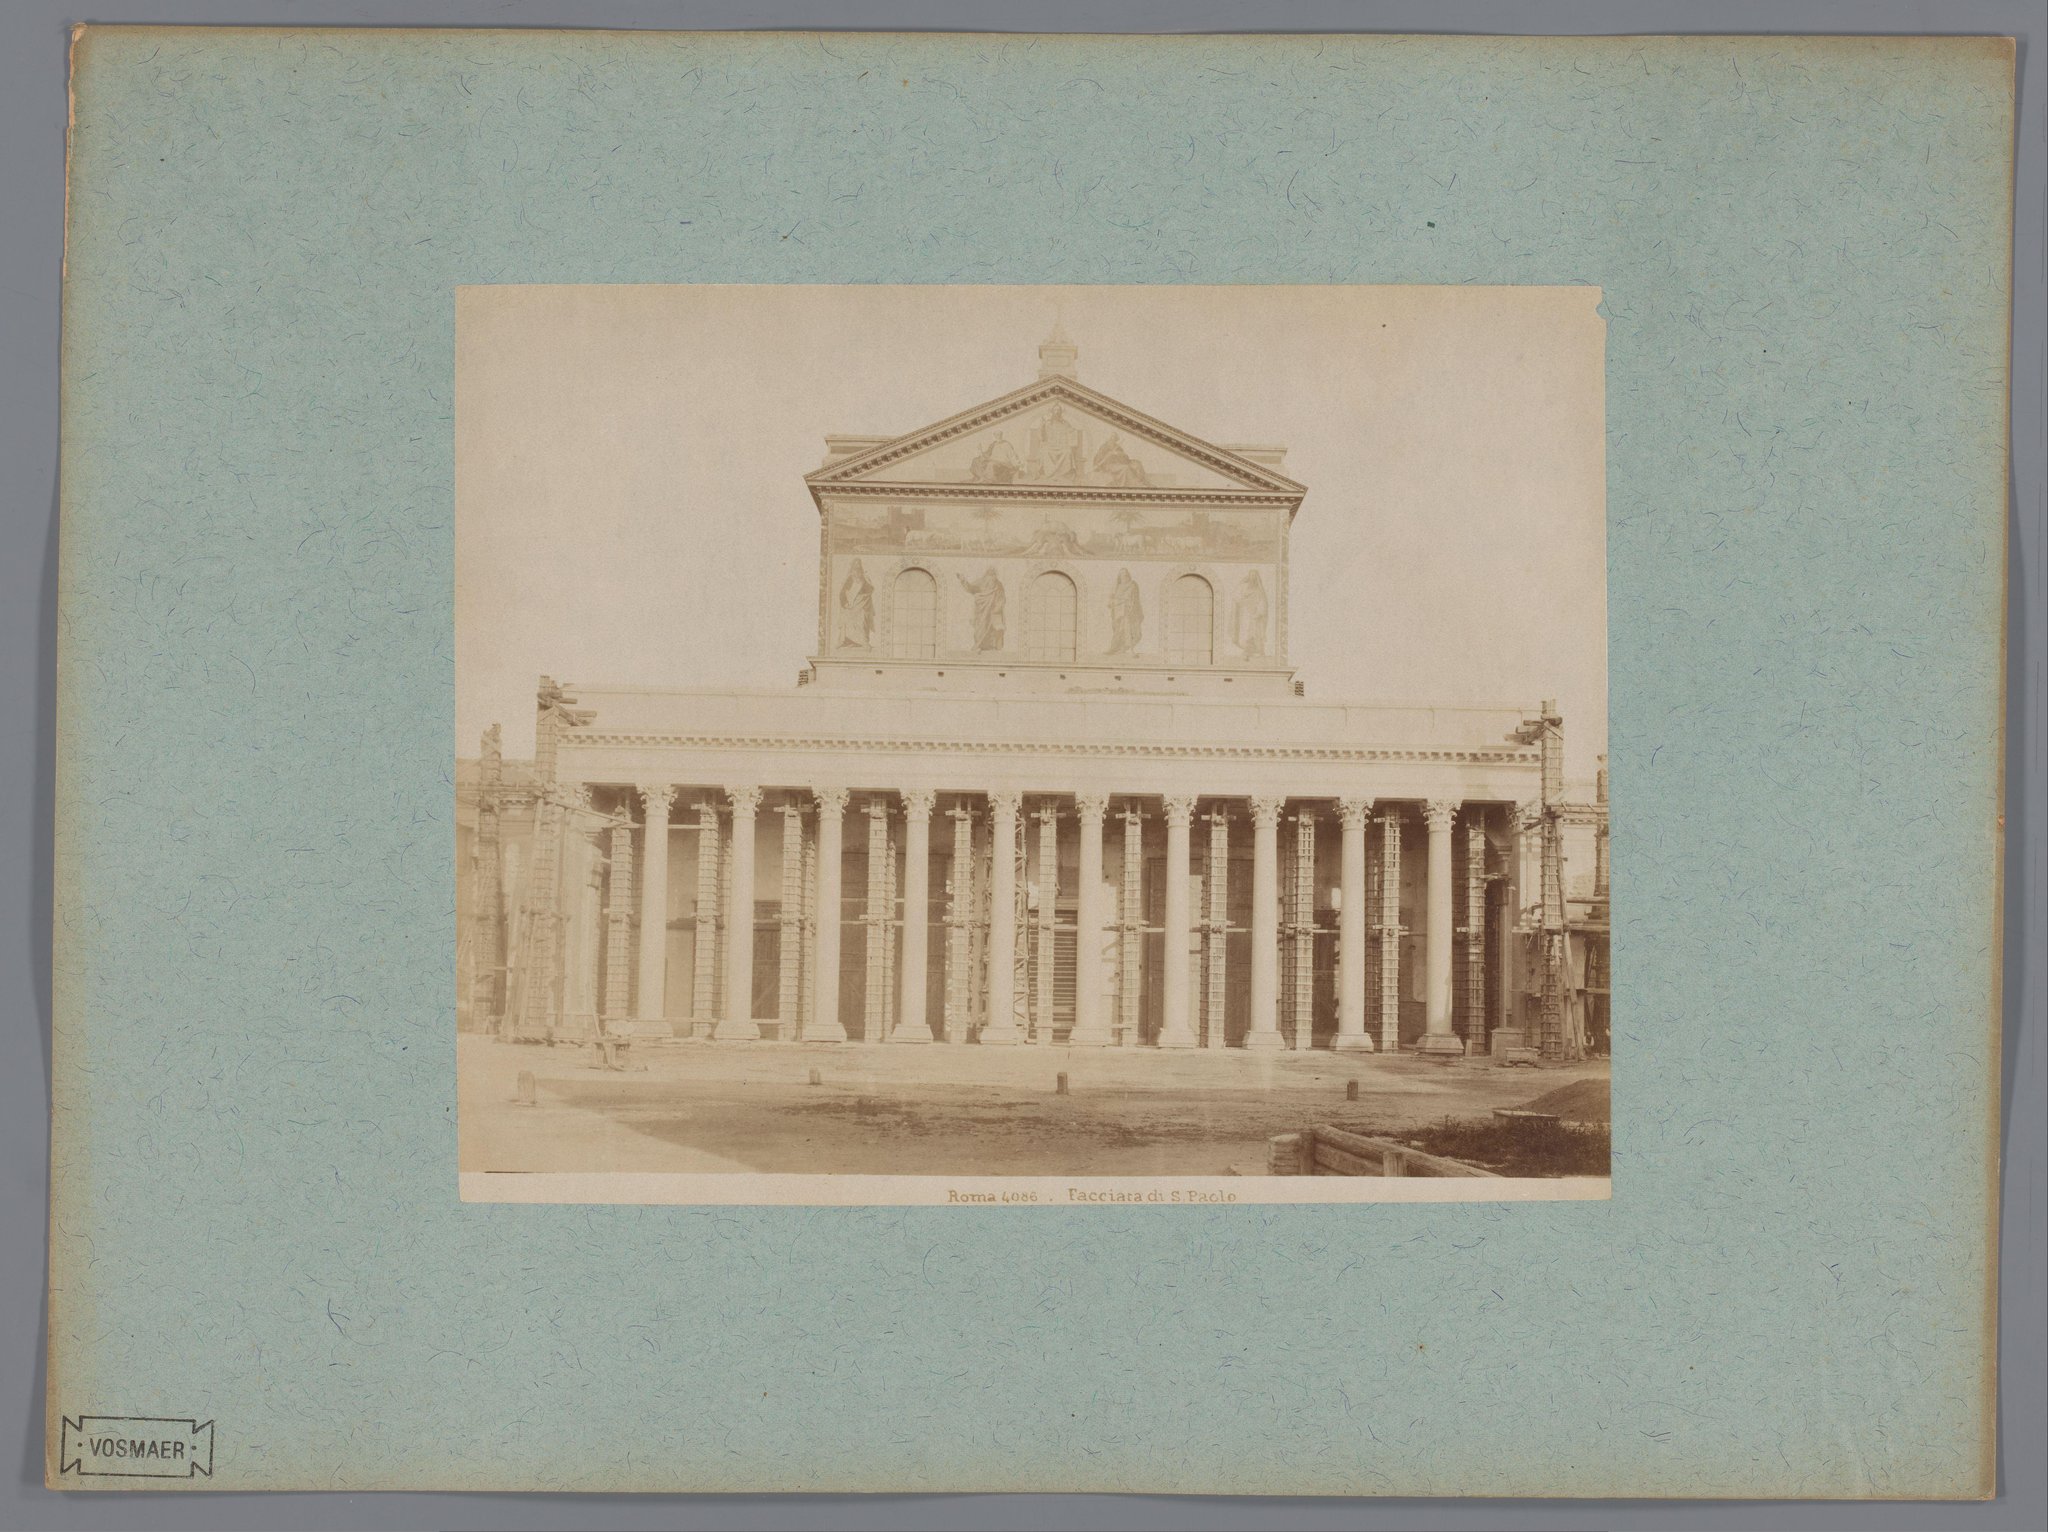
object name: photograph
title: Facciata di S. Paolo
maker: Anonymous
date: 1854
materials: cardboard, paper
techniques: albumen print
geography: rome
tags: church (exterior)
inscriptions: number: ‘4086’, collector's mark: ‘VOSMAER’